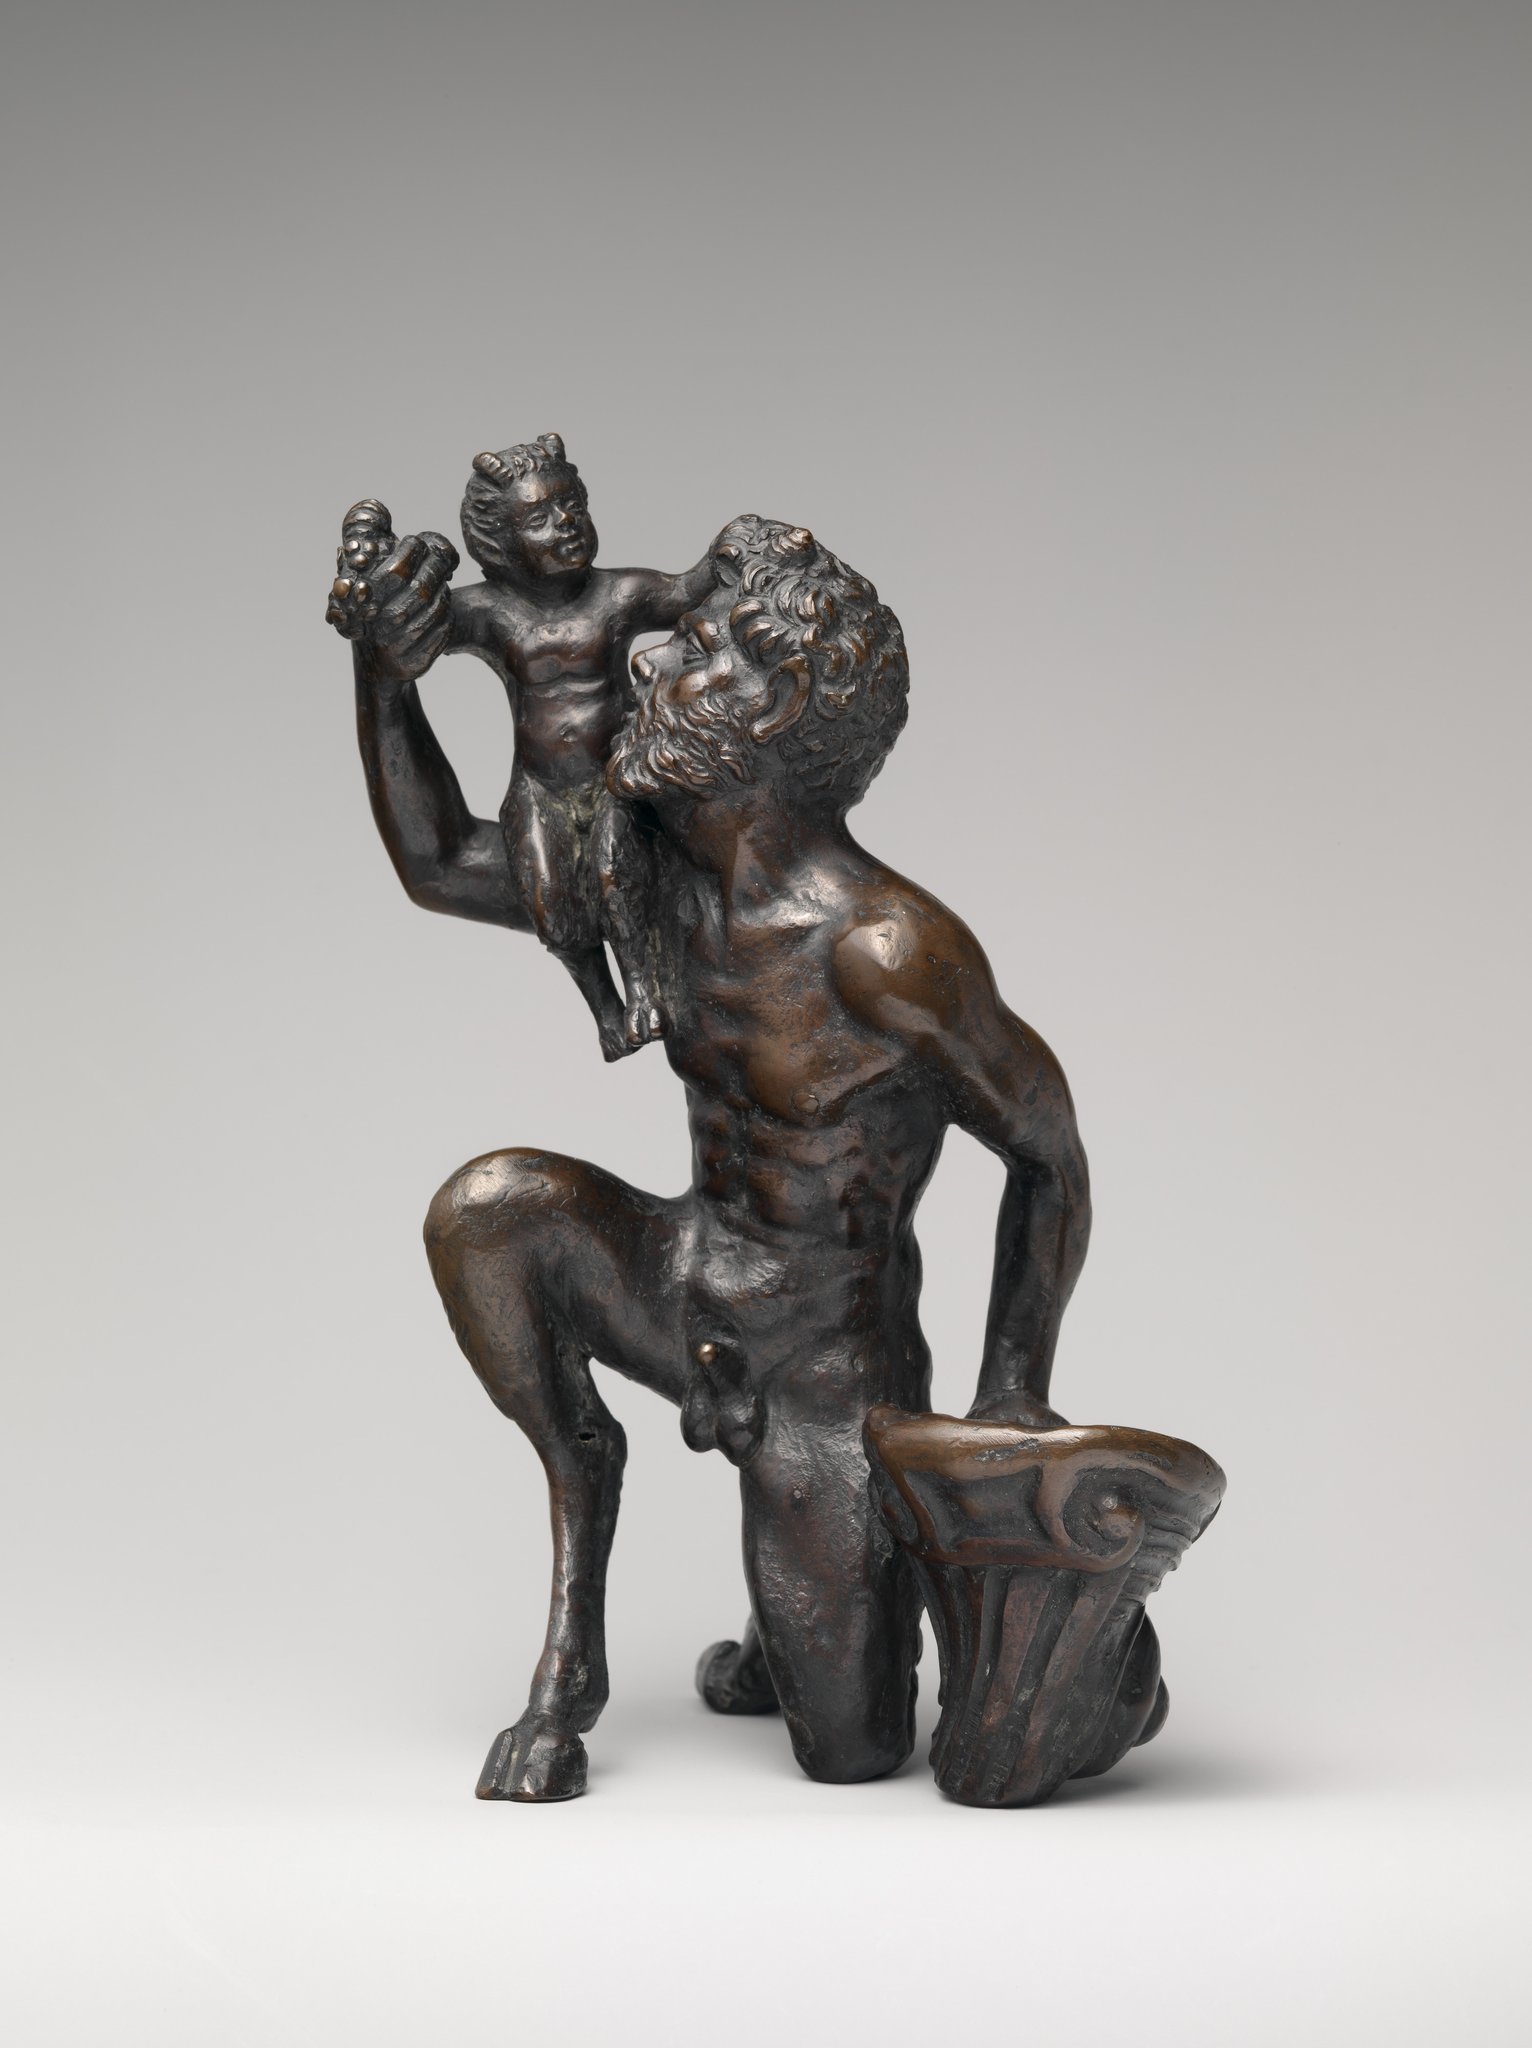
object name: statuette group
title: Satyr Holding a Boy Satyr on his Shoulder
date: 1501-1600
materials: bronze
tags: satyrs